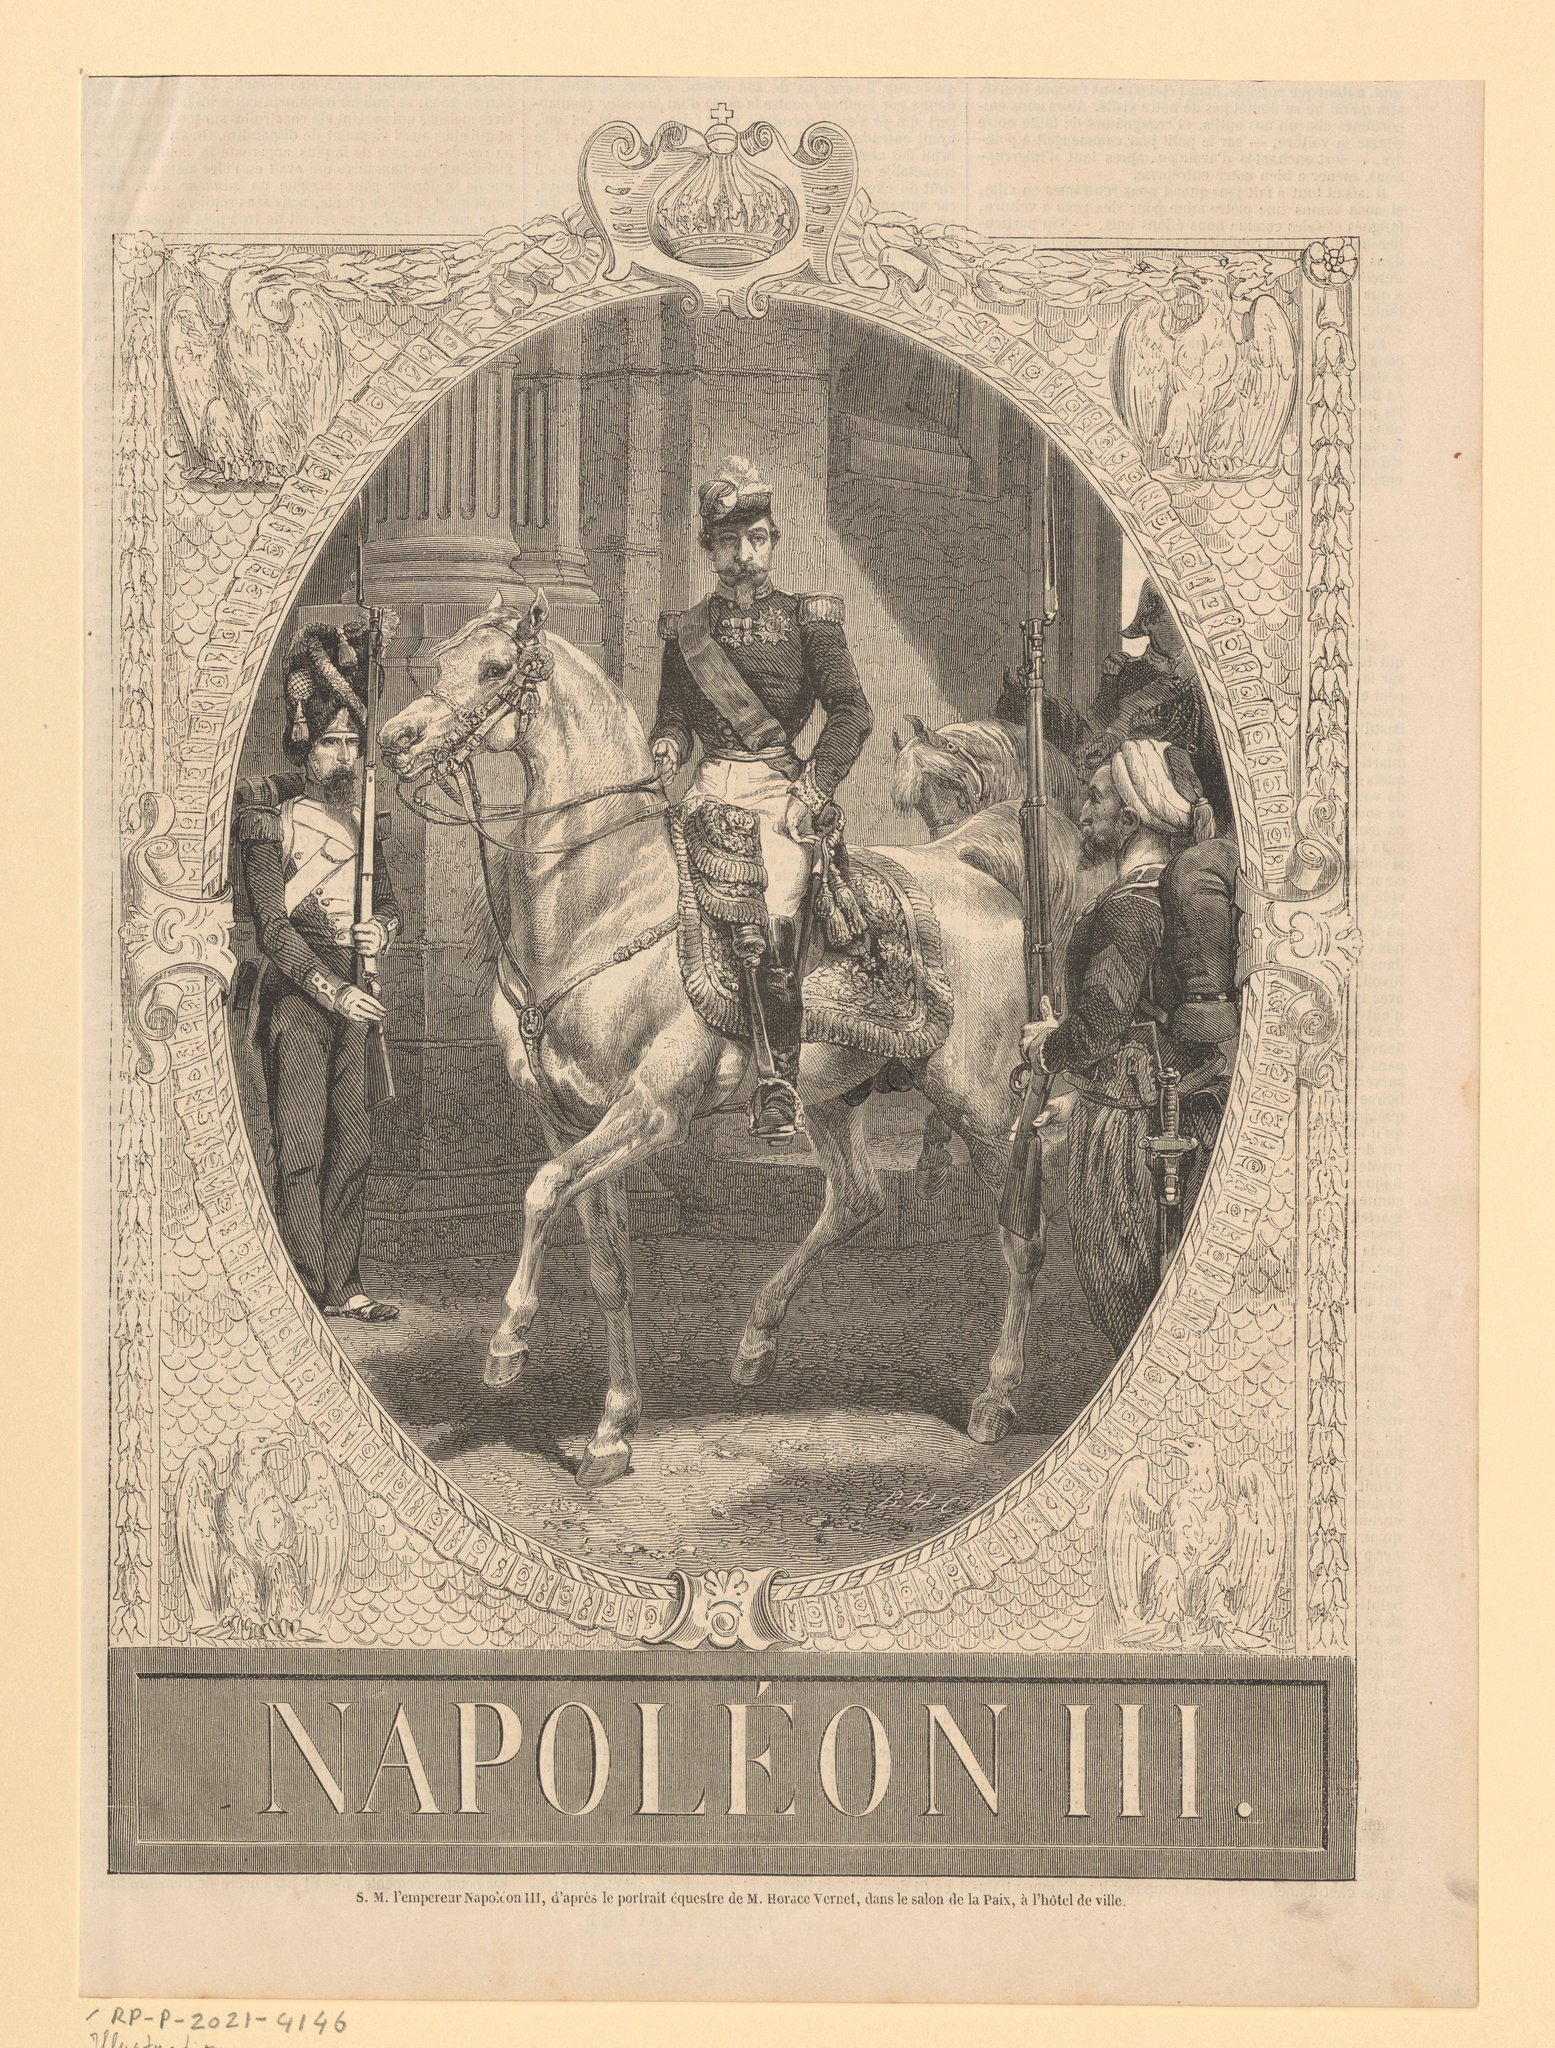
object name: print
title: Ruiterportret van Napoleon III Bonaparte, keizer van Frankrijk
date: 1856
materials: paper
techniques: letterpress printing, engraving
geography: paris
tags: paris, london, napoleon iii (keizer der fransen), president ~ head of republic, private soldier, historical persons, emperor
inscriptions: stamp: ‘L'Illustration/ 23 Aug, 1856’, monogram: ‘BHC’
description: Prent uit: L'Illustration 28 (1856), nr. 704, 23 augustus 1856.